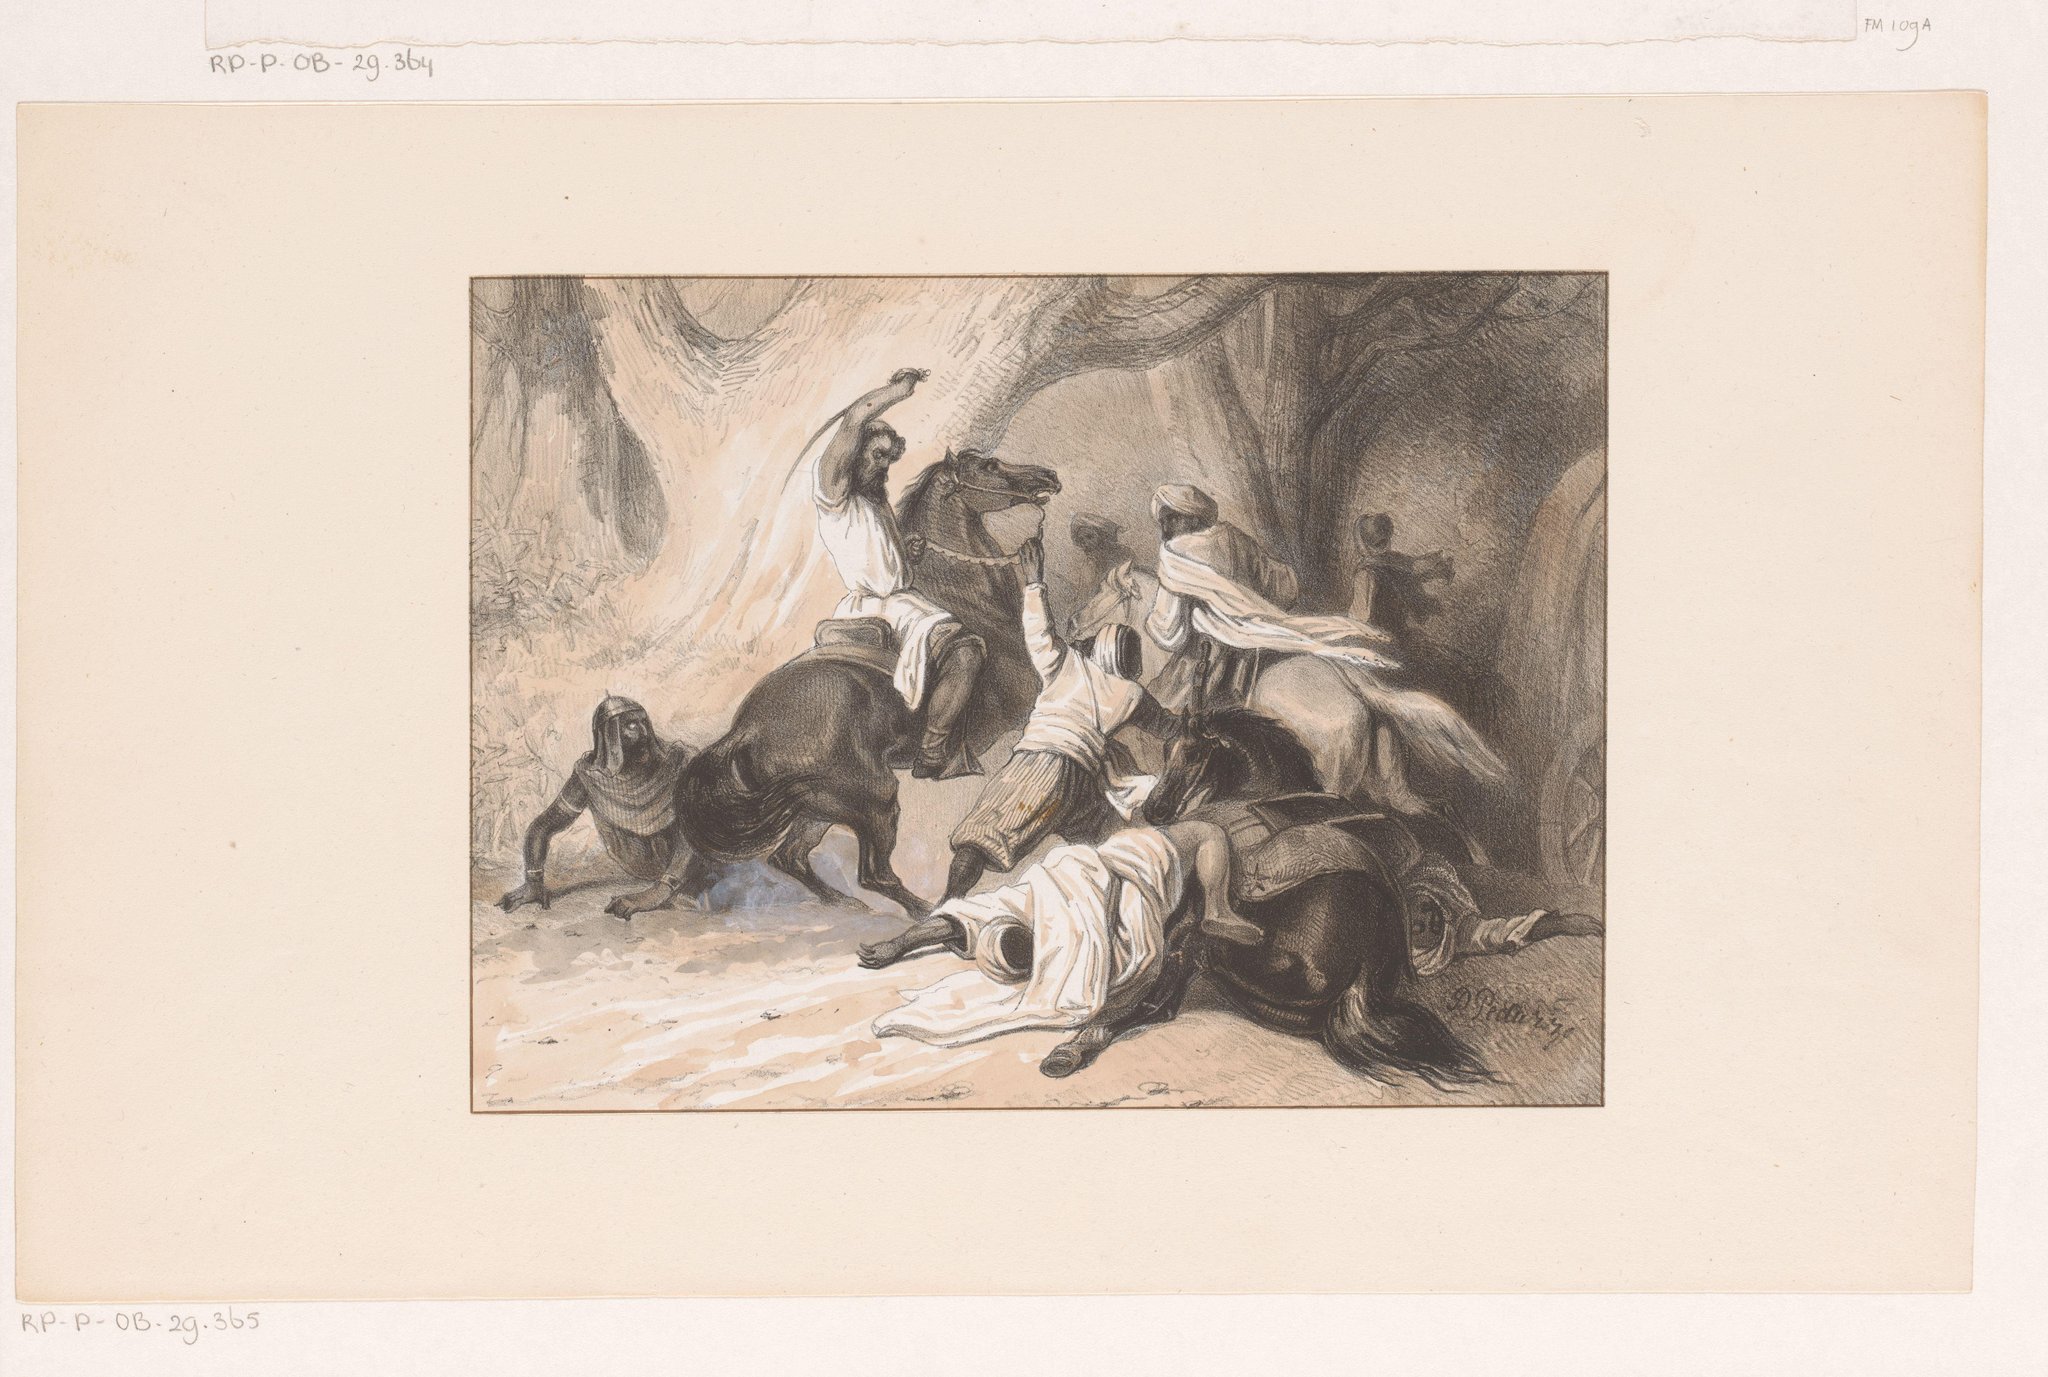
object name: print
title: Willem met de Hoorn, graaf van Orange, bestrijdt de Moren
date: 1827-1861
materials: paper, watercolor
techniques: brush, lithograph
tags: battle, freeing a prisoner; ransoming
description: Willem met de Hoorn, eerste graaf van Orange, verlost zijn vier geroofde kinderen uit de handen van de Moren, in het jaar 806.